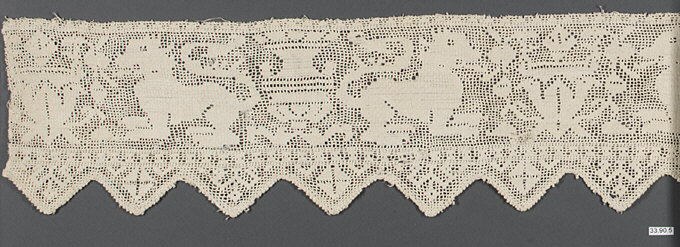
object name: border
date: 1501-1600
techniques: embroidery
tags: animals